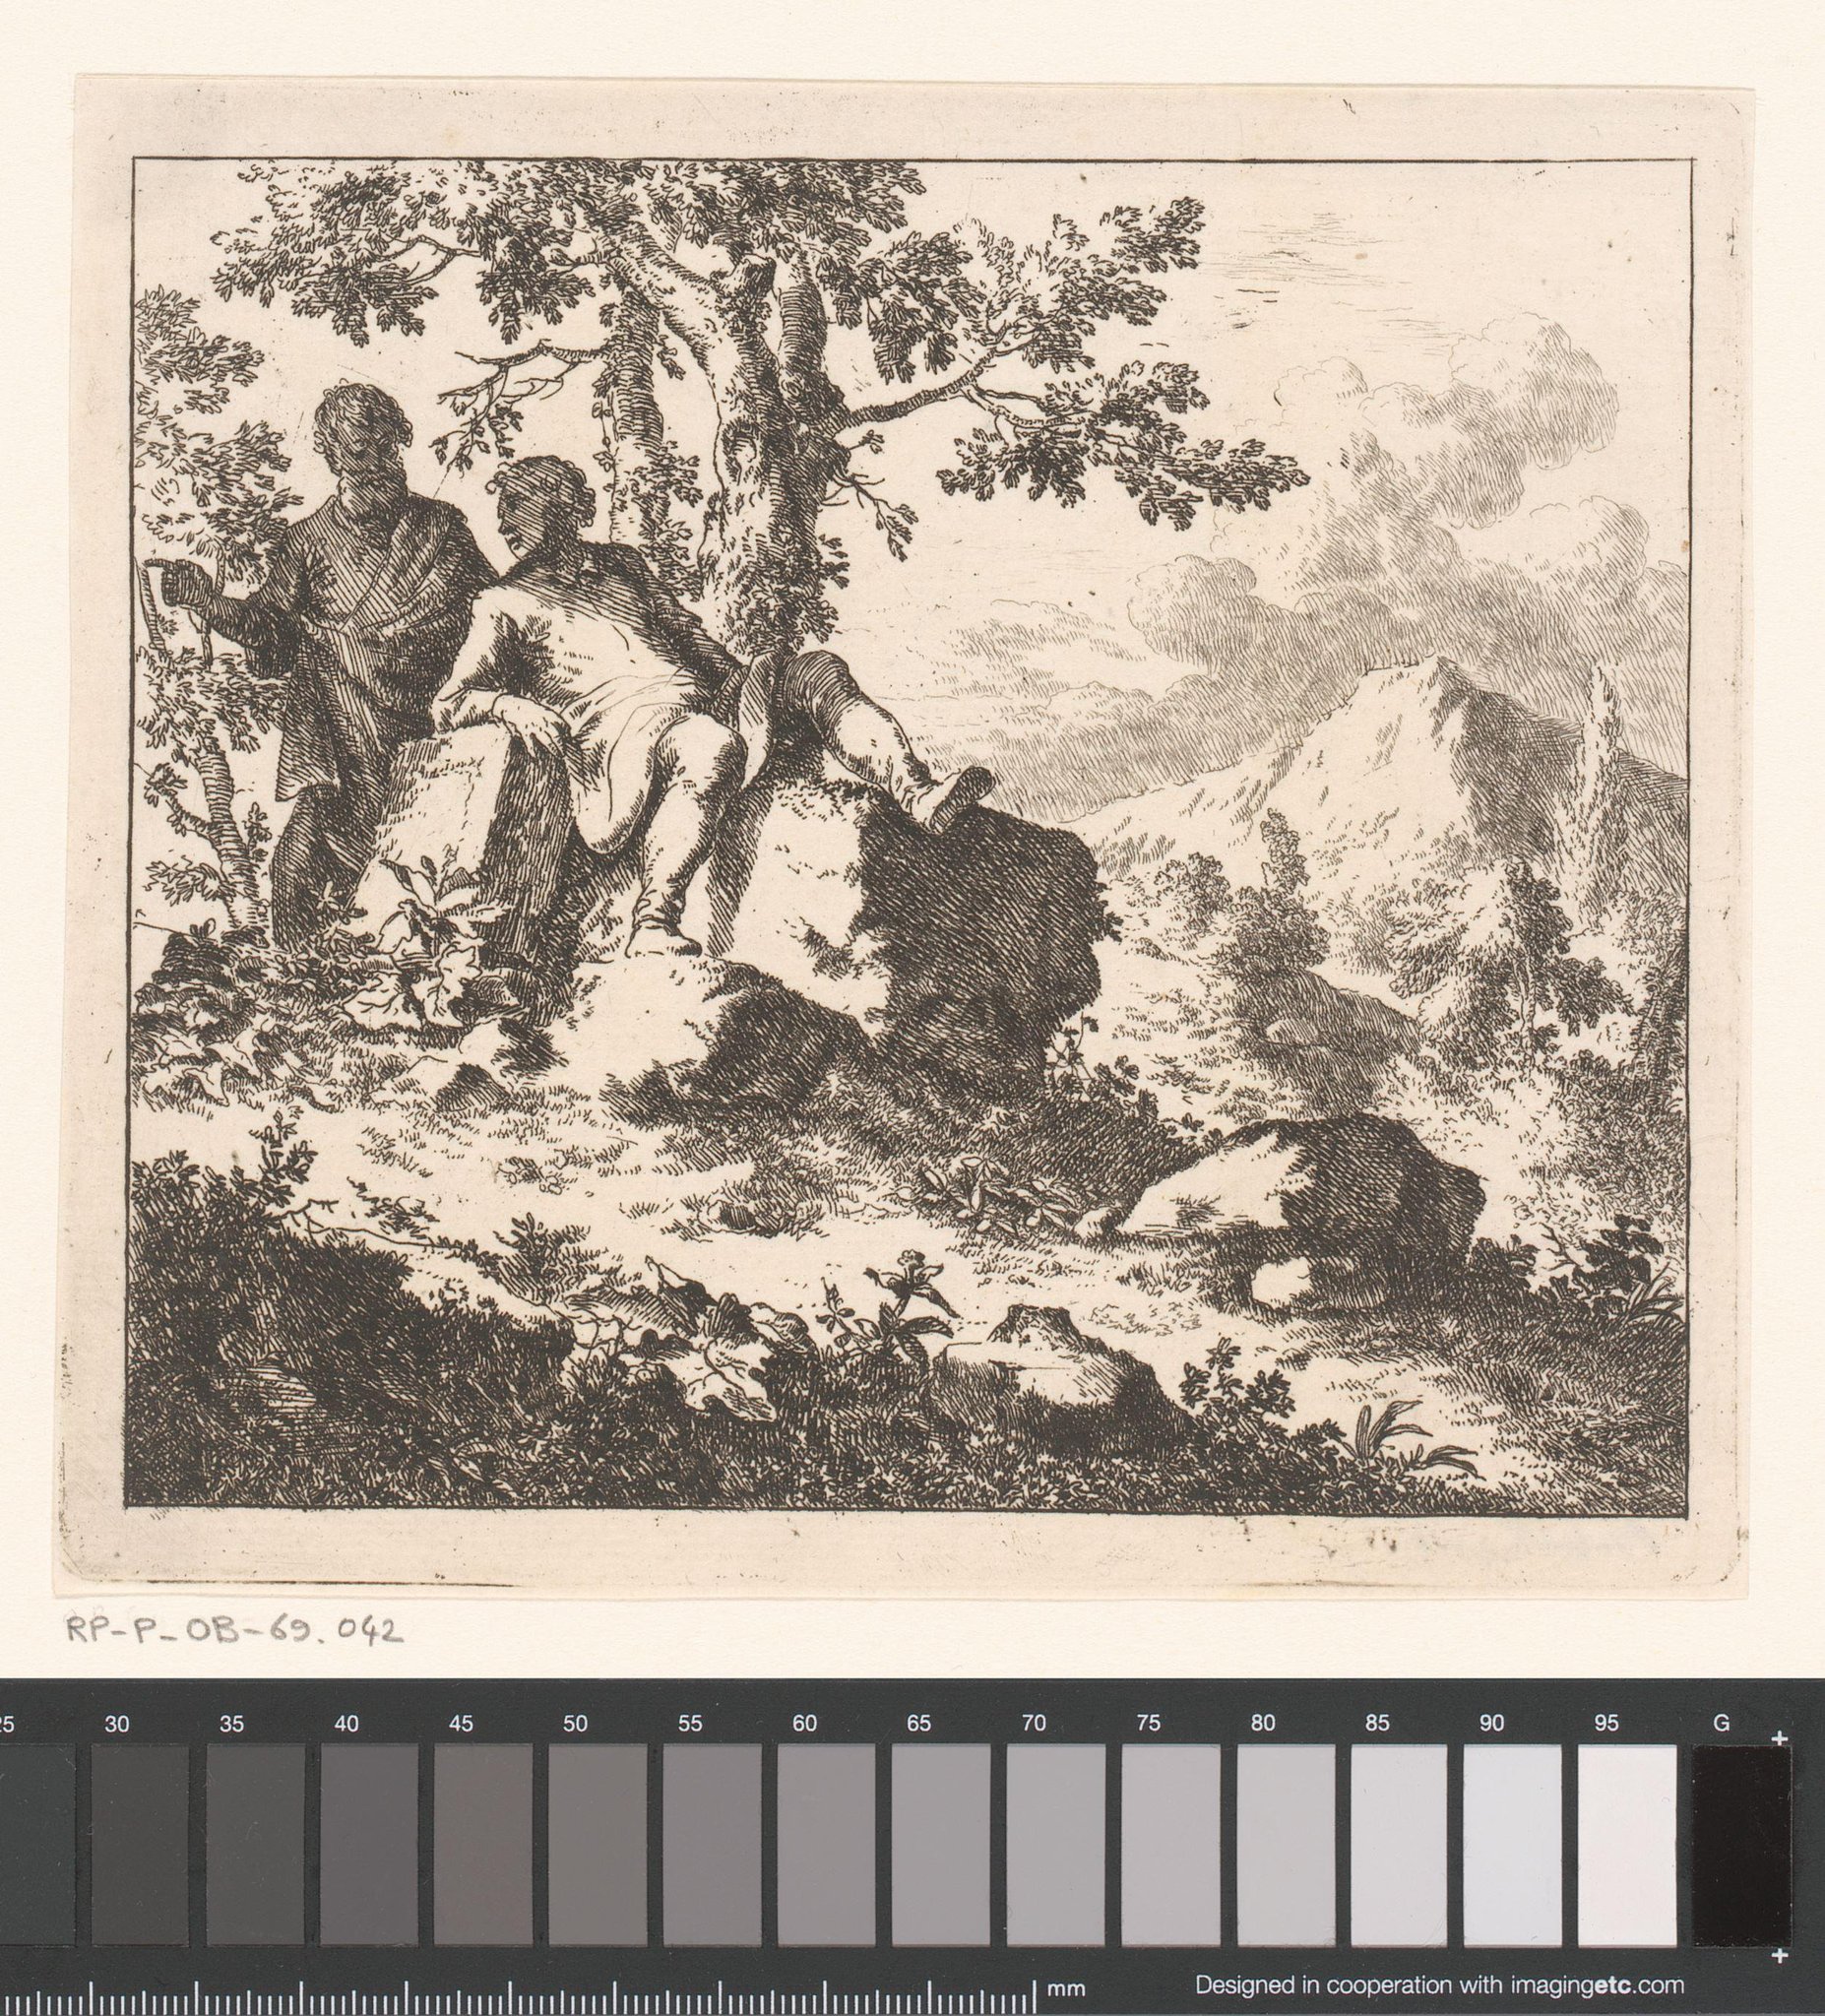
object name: print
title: Heuvelachtig landschap met twee mannen bij een steen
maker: jacques-philippe le bas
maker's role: draughtsman, print maker, publisher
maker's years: 1707-1783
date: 1717-1783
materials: paper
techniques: etching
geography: paris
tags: landscapes, (traveller) resting in the open air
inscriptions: collector's mark: Lugt 240